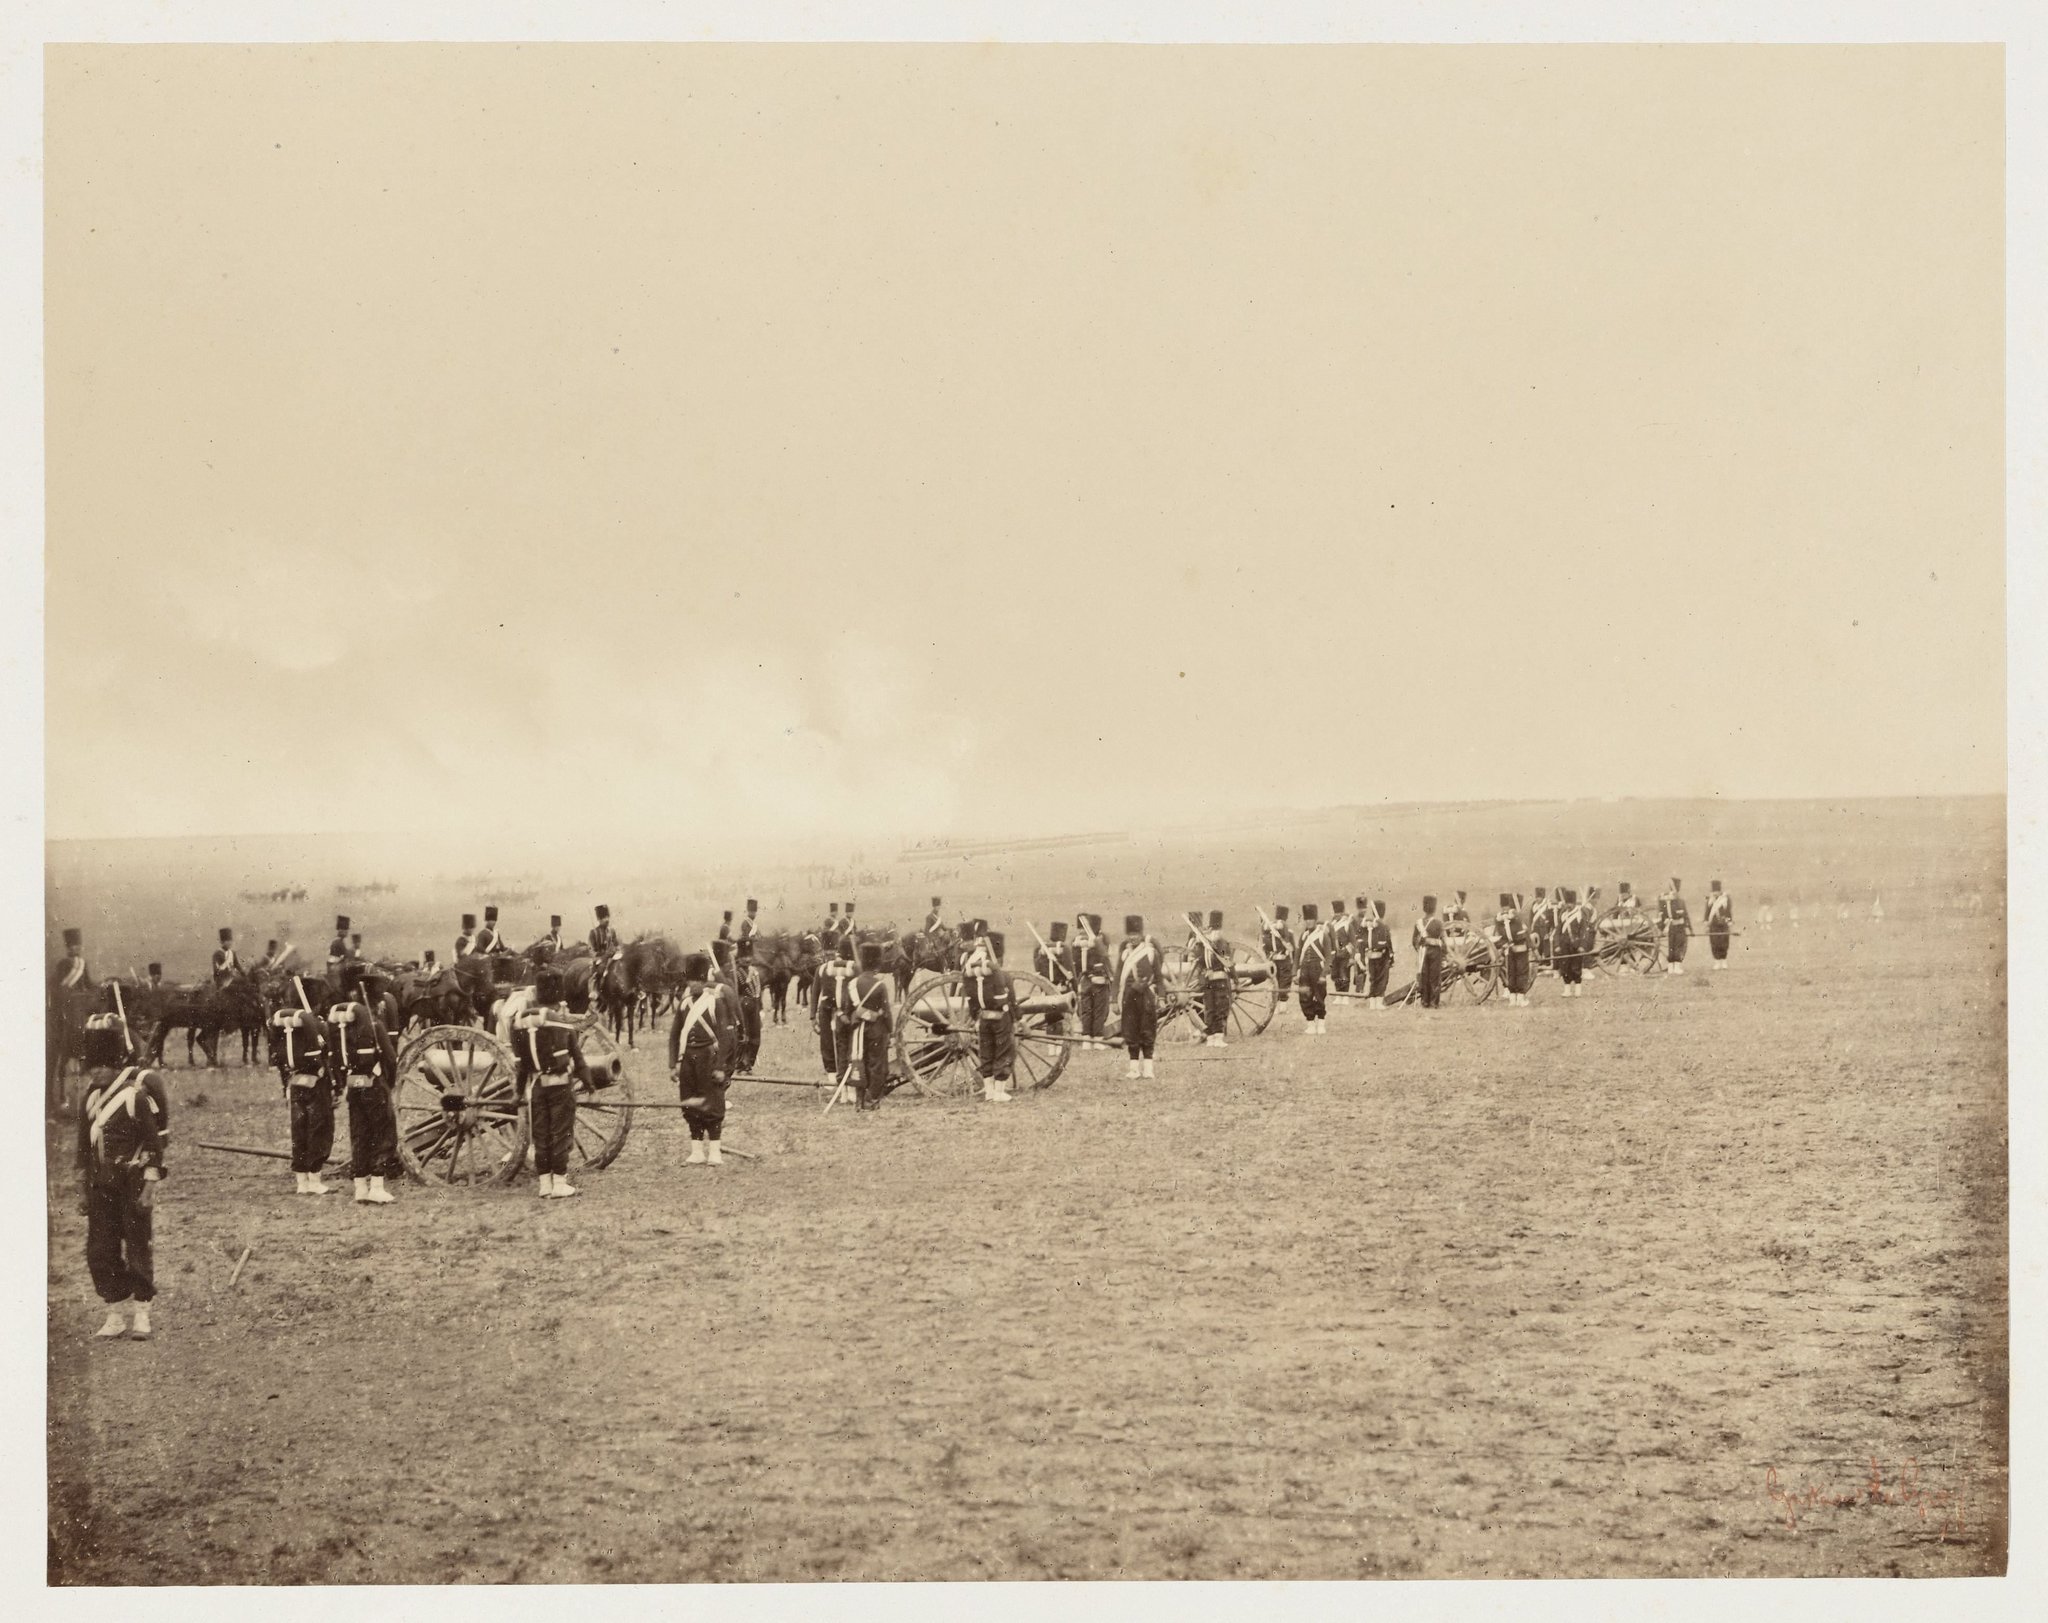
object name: photograph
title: Manoeuvres in het Camp de Châlons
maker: gustave le gray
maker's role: fotograaf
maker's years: 1820-1884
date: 1857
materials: cardboard, photographic support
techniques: albumen print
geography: france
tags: camp de châlons